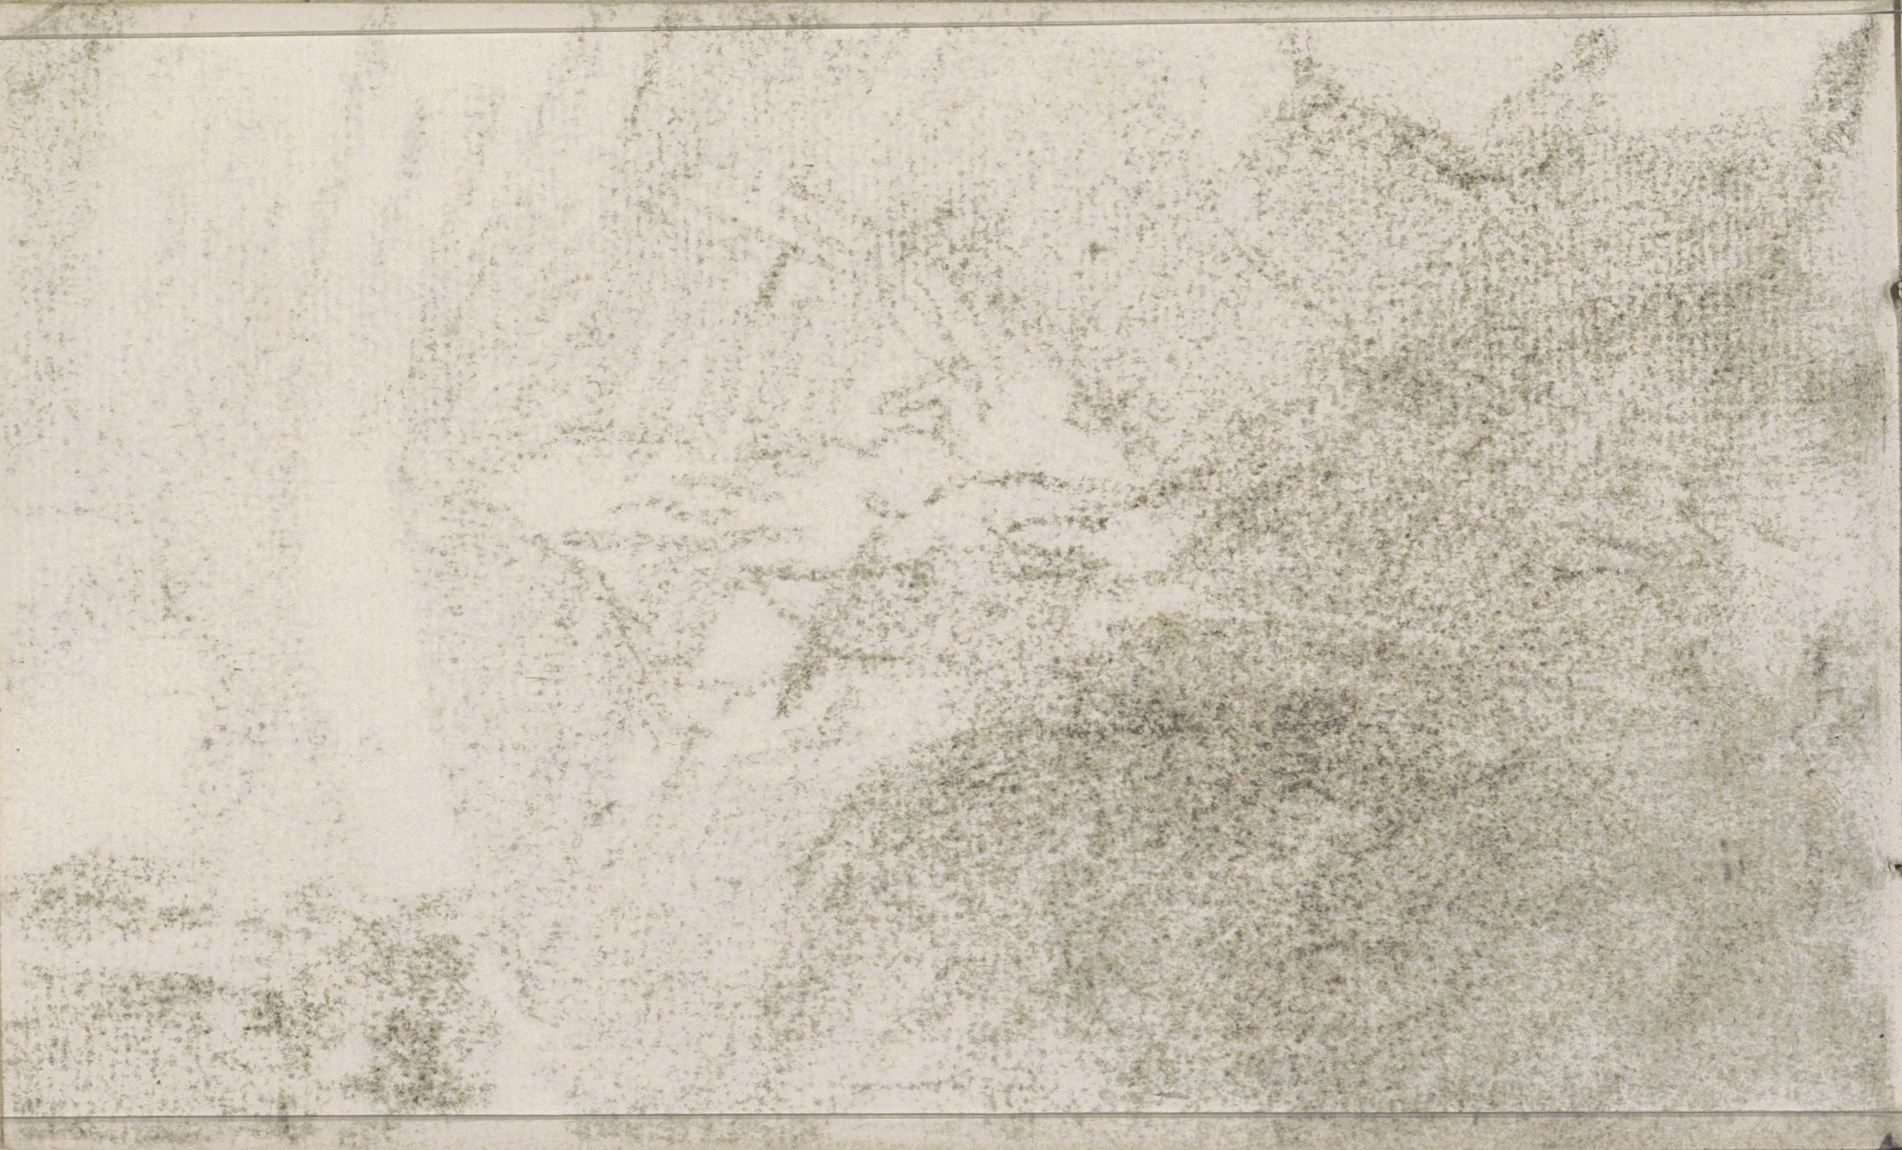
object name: sketchbook leaf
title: Abklatsch van de krijttekening op pagina 35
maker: isaac israels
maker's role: draughtsman, painter, print maker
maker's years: 1865-1934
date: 1875-1934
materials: paper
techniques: printmaking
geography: the hague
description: Pagina 34 uit schetsboek XLVIII met 62 pagina's.